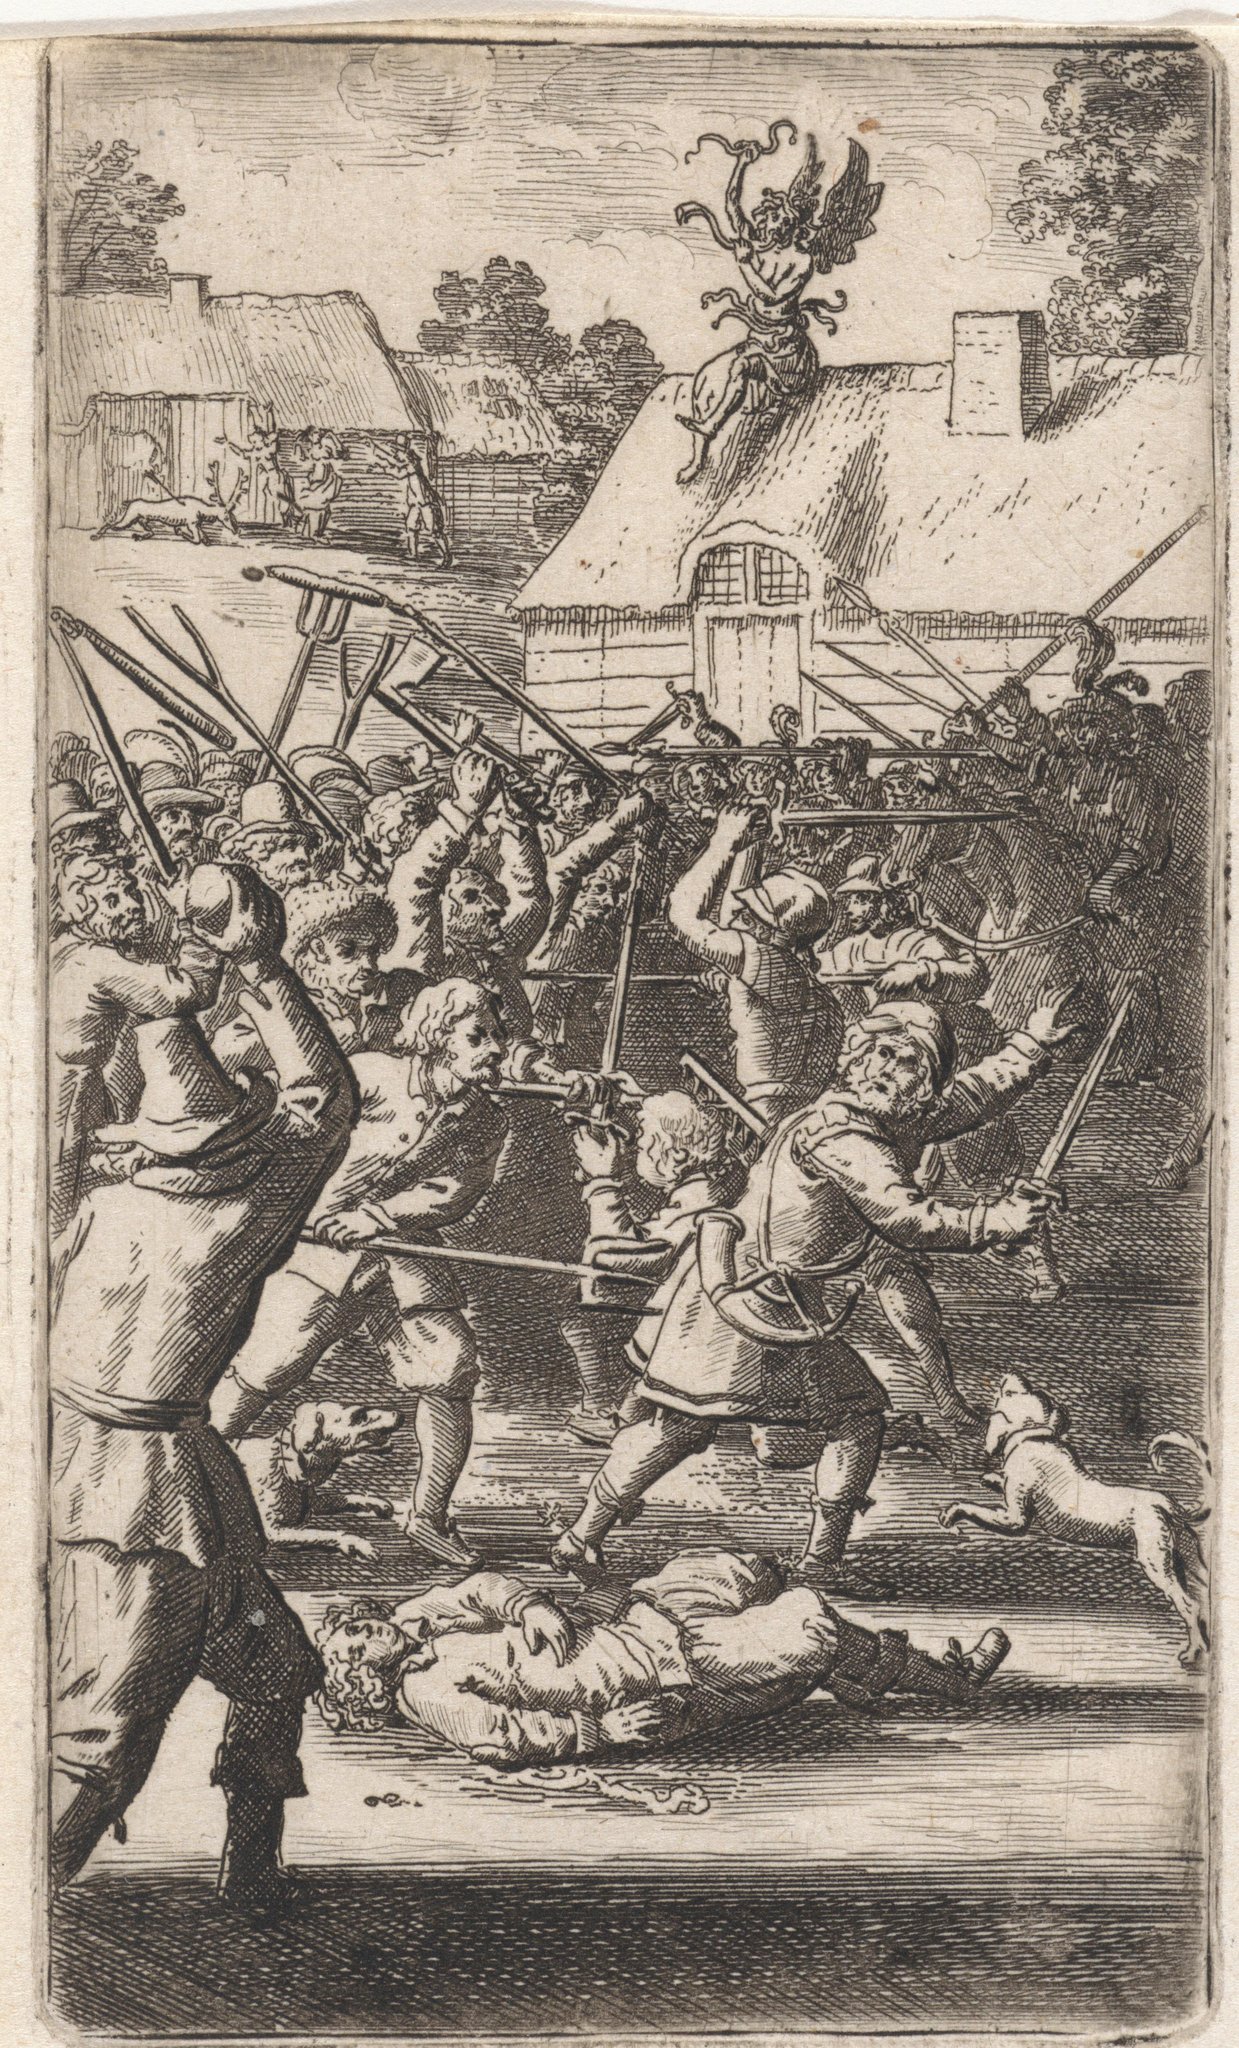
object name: print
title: Gevecht in een dorp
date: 1668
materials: paper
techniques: etching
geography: netherlands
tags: fabulous beings with wings - aa - female human figure, hunter, battle, fight between farmers and soldiers, hoofed animals: deer (+ animal killed by man), farm (building)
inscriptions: collector's mark: Lugt 2228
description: Bij een dorp met enkele boerderijen vecht een grote groep boeren met werktuigen tegen enkele soldaten en een jager. Bij de jager ligt een man op de grond en voor hem springt een hond op. Linksachter staan mensen met opgeheven armen bij een hert met een pijl in zijn lichaam.